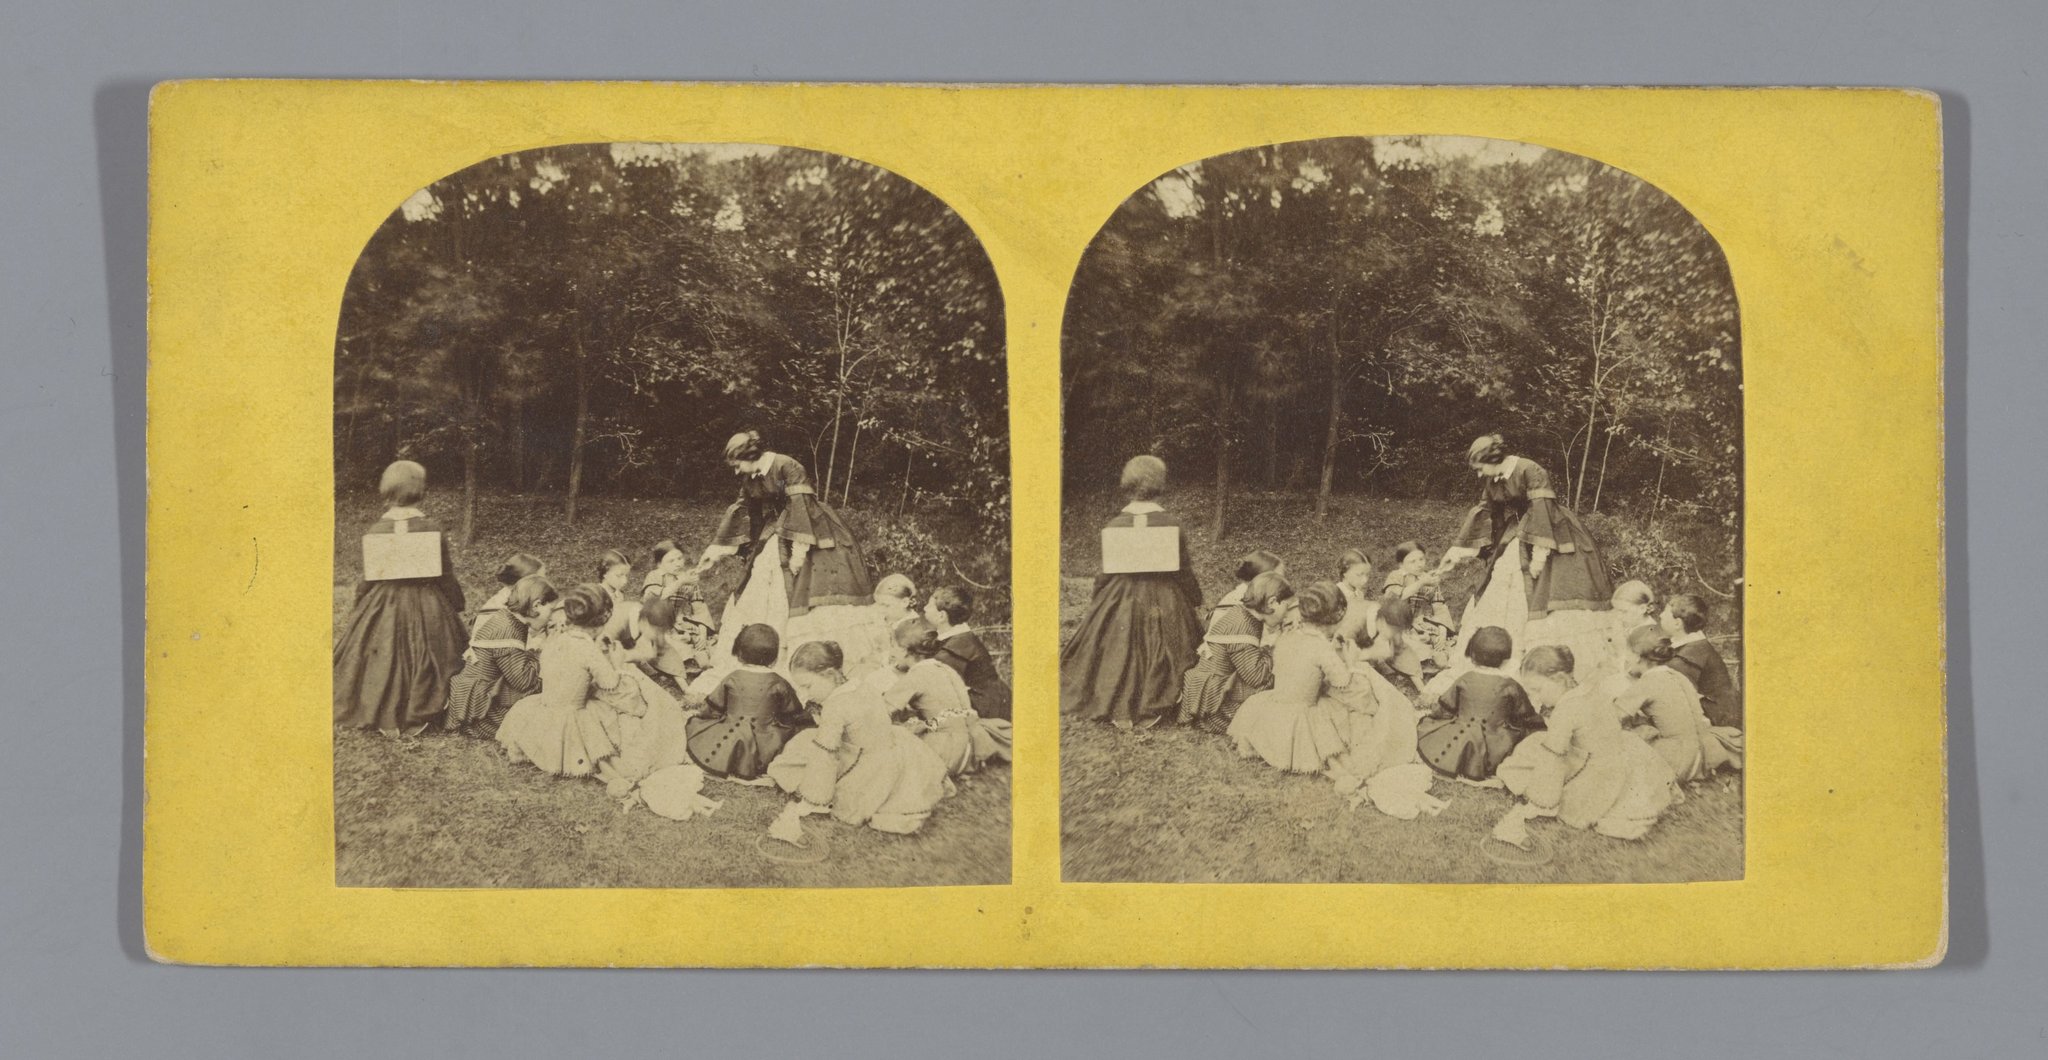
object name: stereograph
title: Klas schoolmeisjes en een lerares op het gras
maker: Anonymous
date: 1850-1880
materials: cardboard, photographic support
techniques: albumen print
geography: europe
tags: child and school (~ games and plays), elementary school; class, form, europe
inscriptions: inscription: ‘1,-’